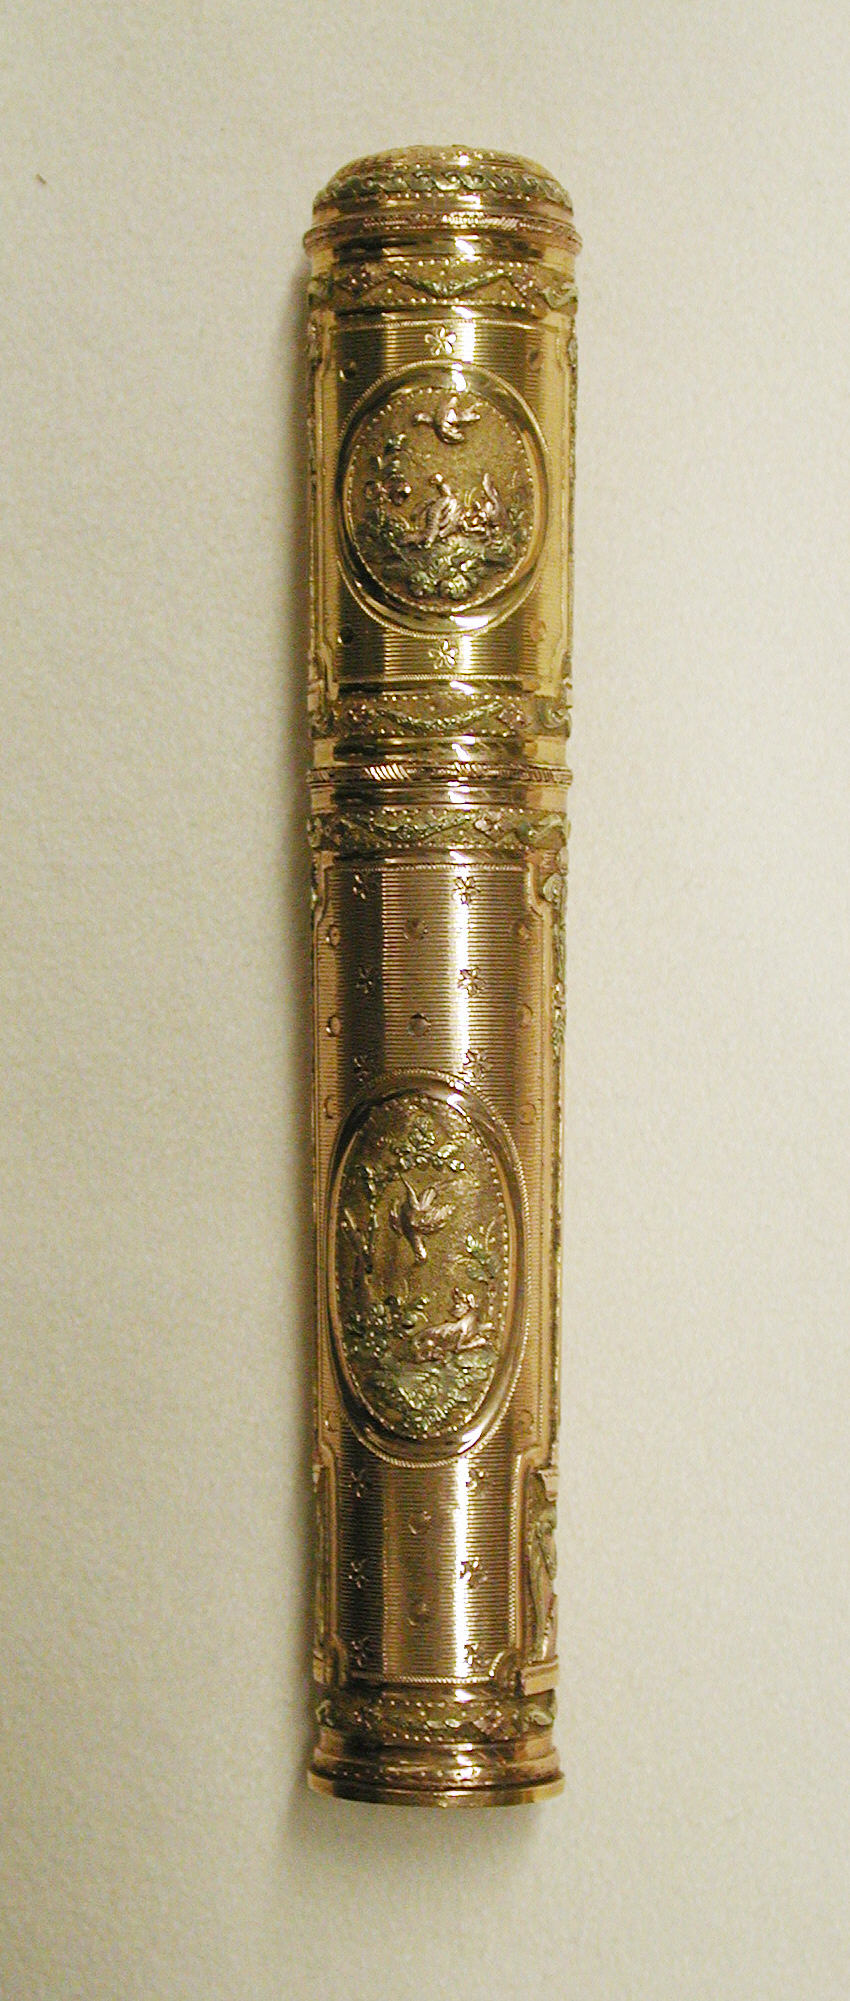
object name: étui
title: Étui for sealing wax and case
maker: antoine-louis anthiaume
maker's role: maker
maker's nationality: french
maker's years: 1784-1806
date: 1785-1786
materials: gold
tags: animals,birds